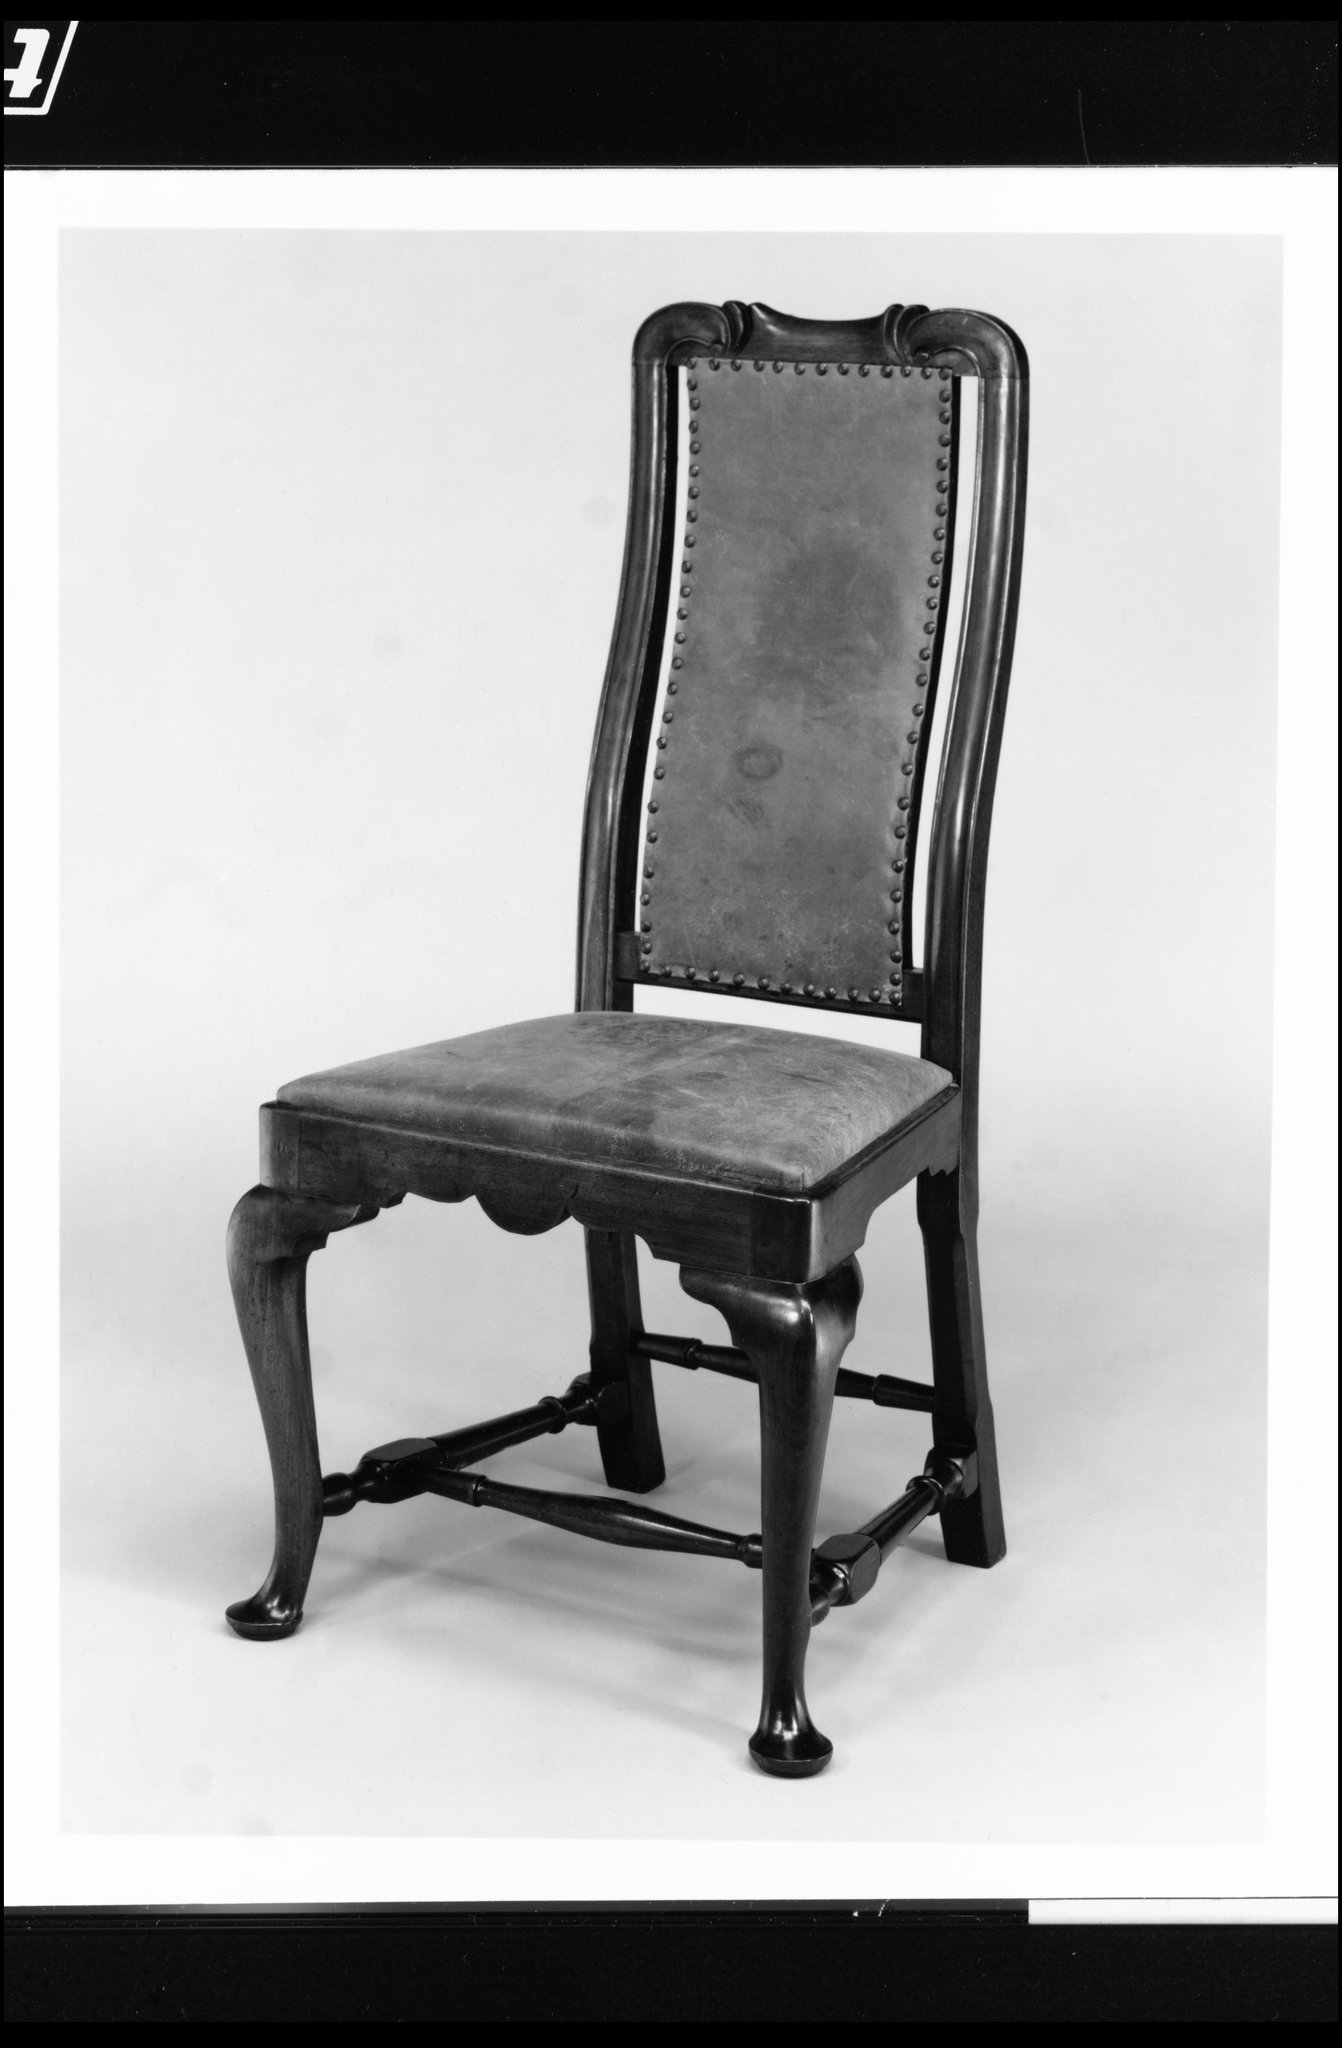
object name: side chair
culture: american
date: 1730-1760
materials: wood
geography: united states